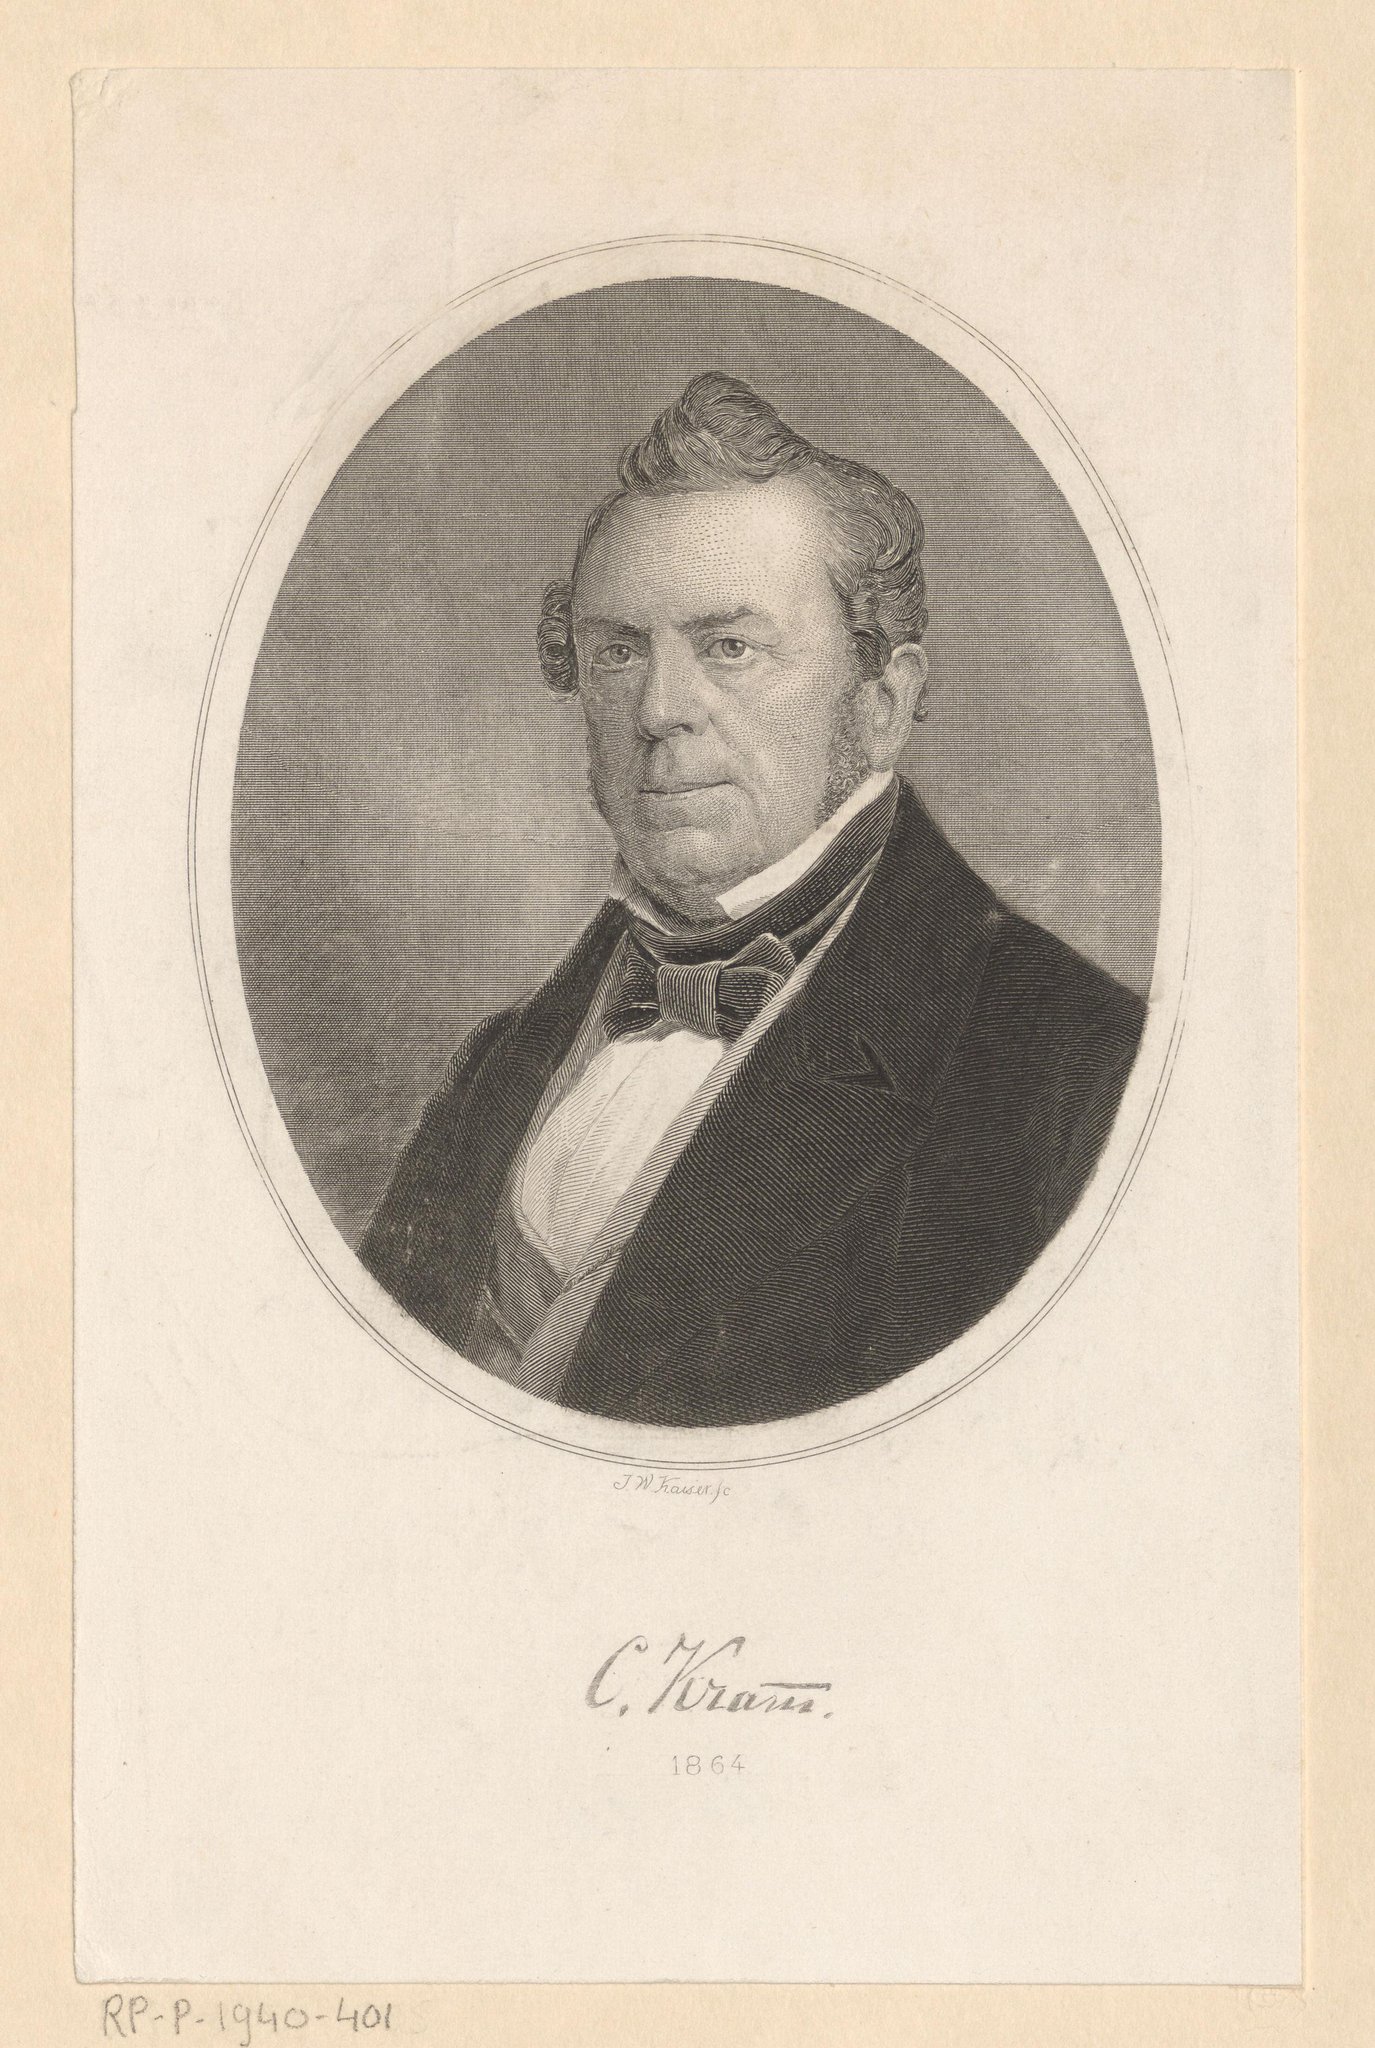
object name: print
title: Portret van Christiaan Kramm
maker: johann wilhelm kaiser (i)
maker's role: draughtsman, print maker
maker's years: 1813-1900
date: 1864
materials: paper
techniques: engraving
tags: utrecht, print maker, draughtsman, christiaan kramm, historical persons, portrait, self-portrait of painter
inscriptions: date